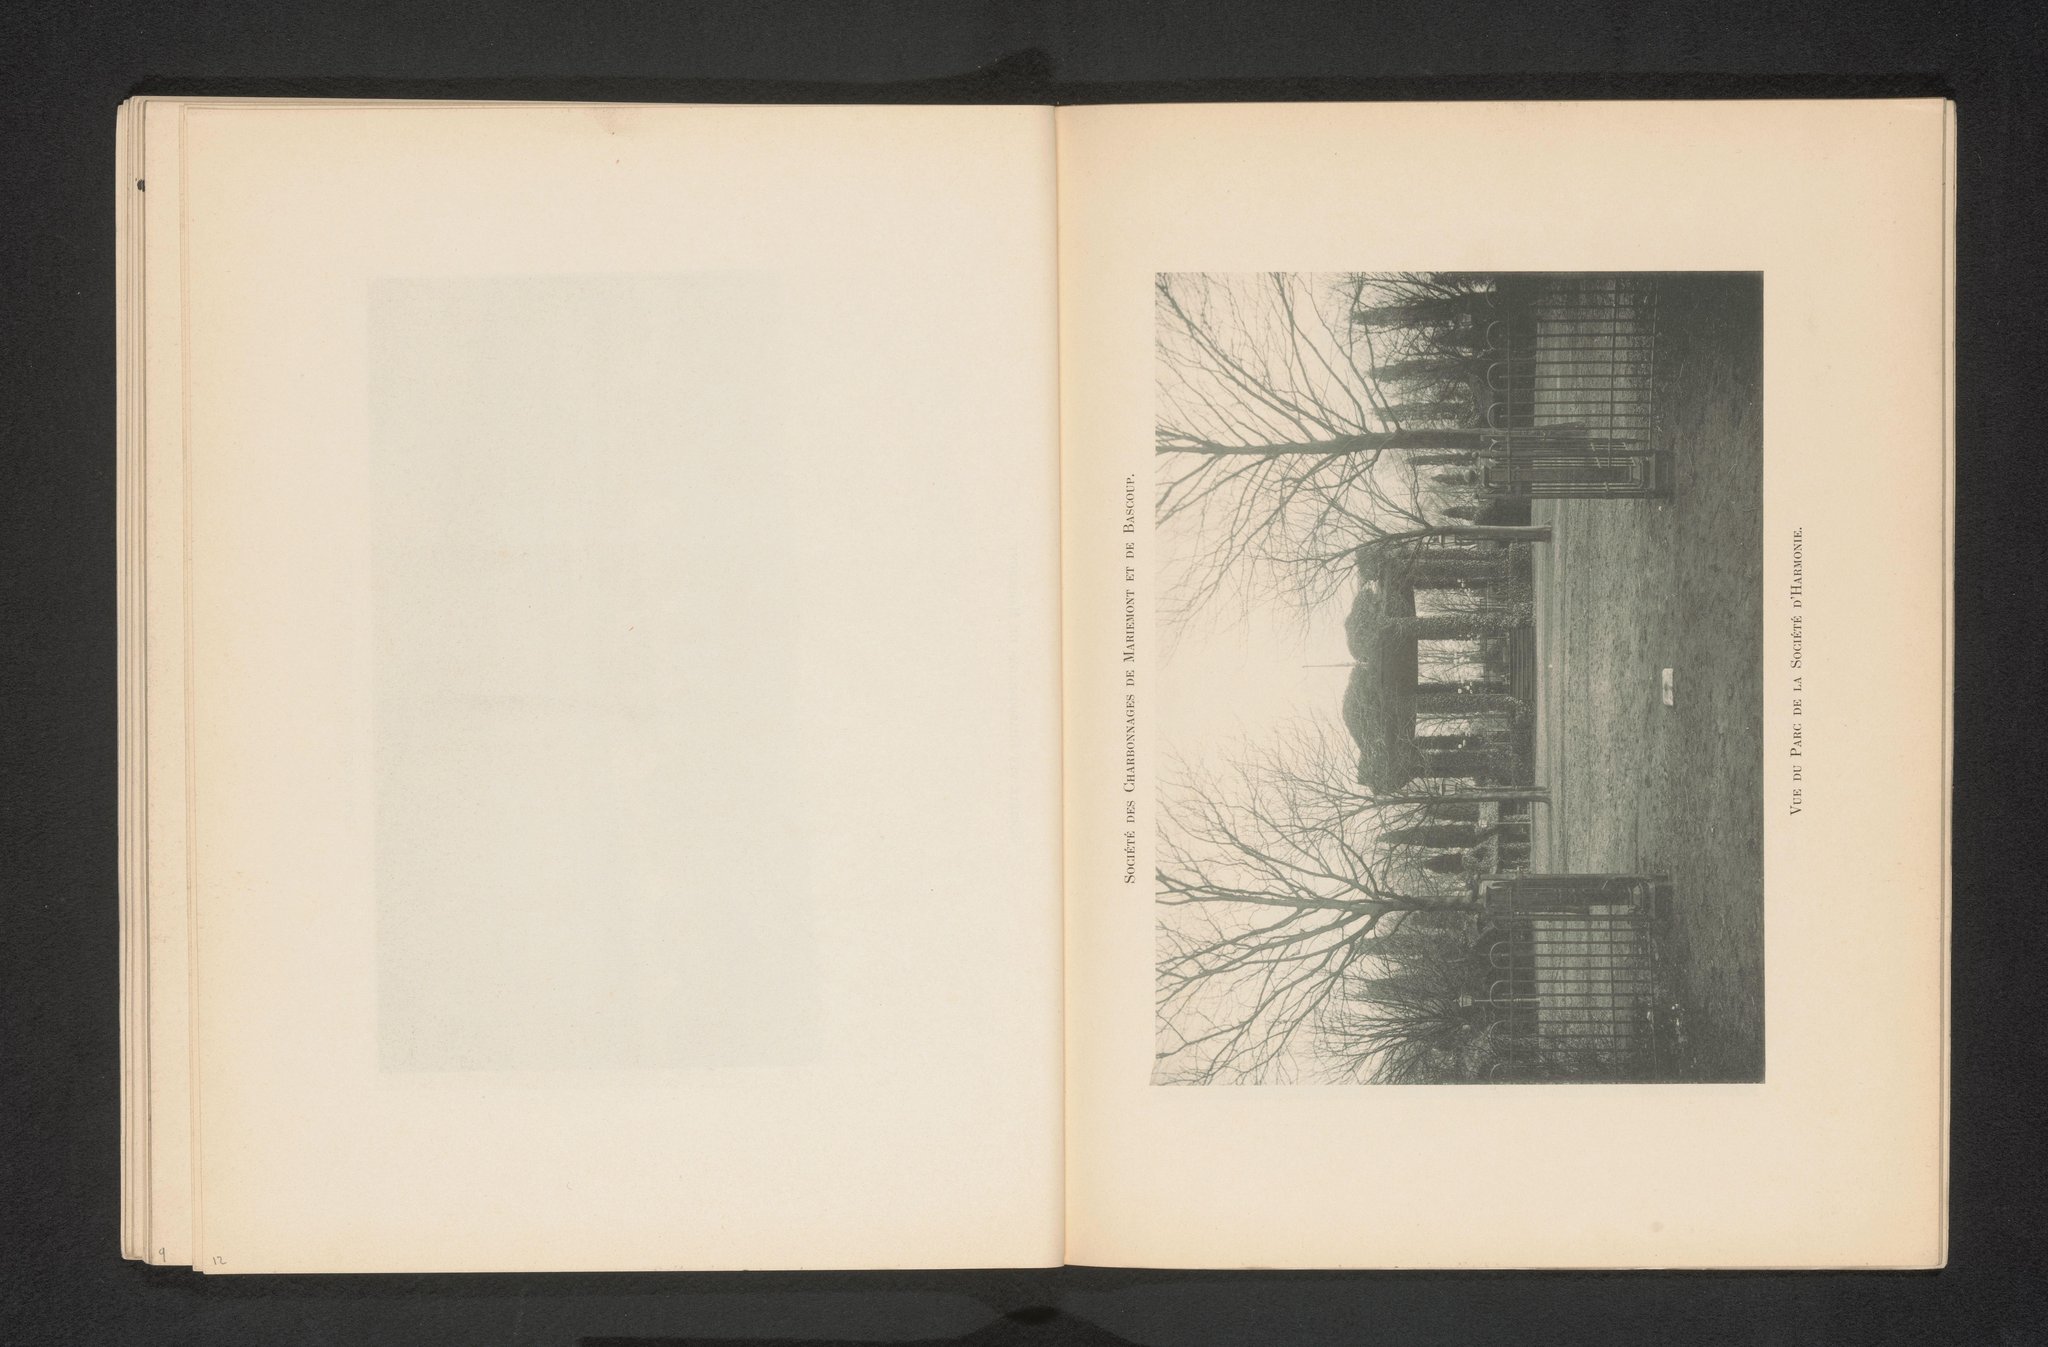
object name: page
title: Vue du Parc de la Société d'Harmonie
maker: Anonymous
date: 1895-1900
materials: paper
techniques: photograph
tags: public gardens, park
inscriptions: inscription: ‘Société des Charbonnages de Mariemont’